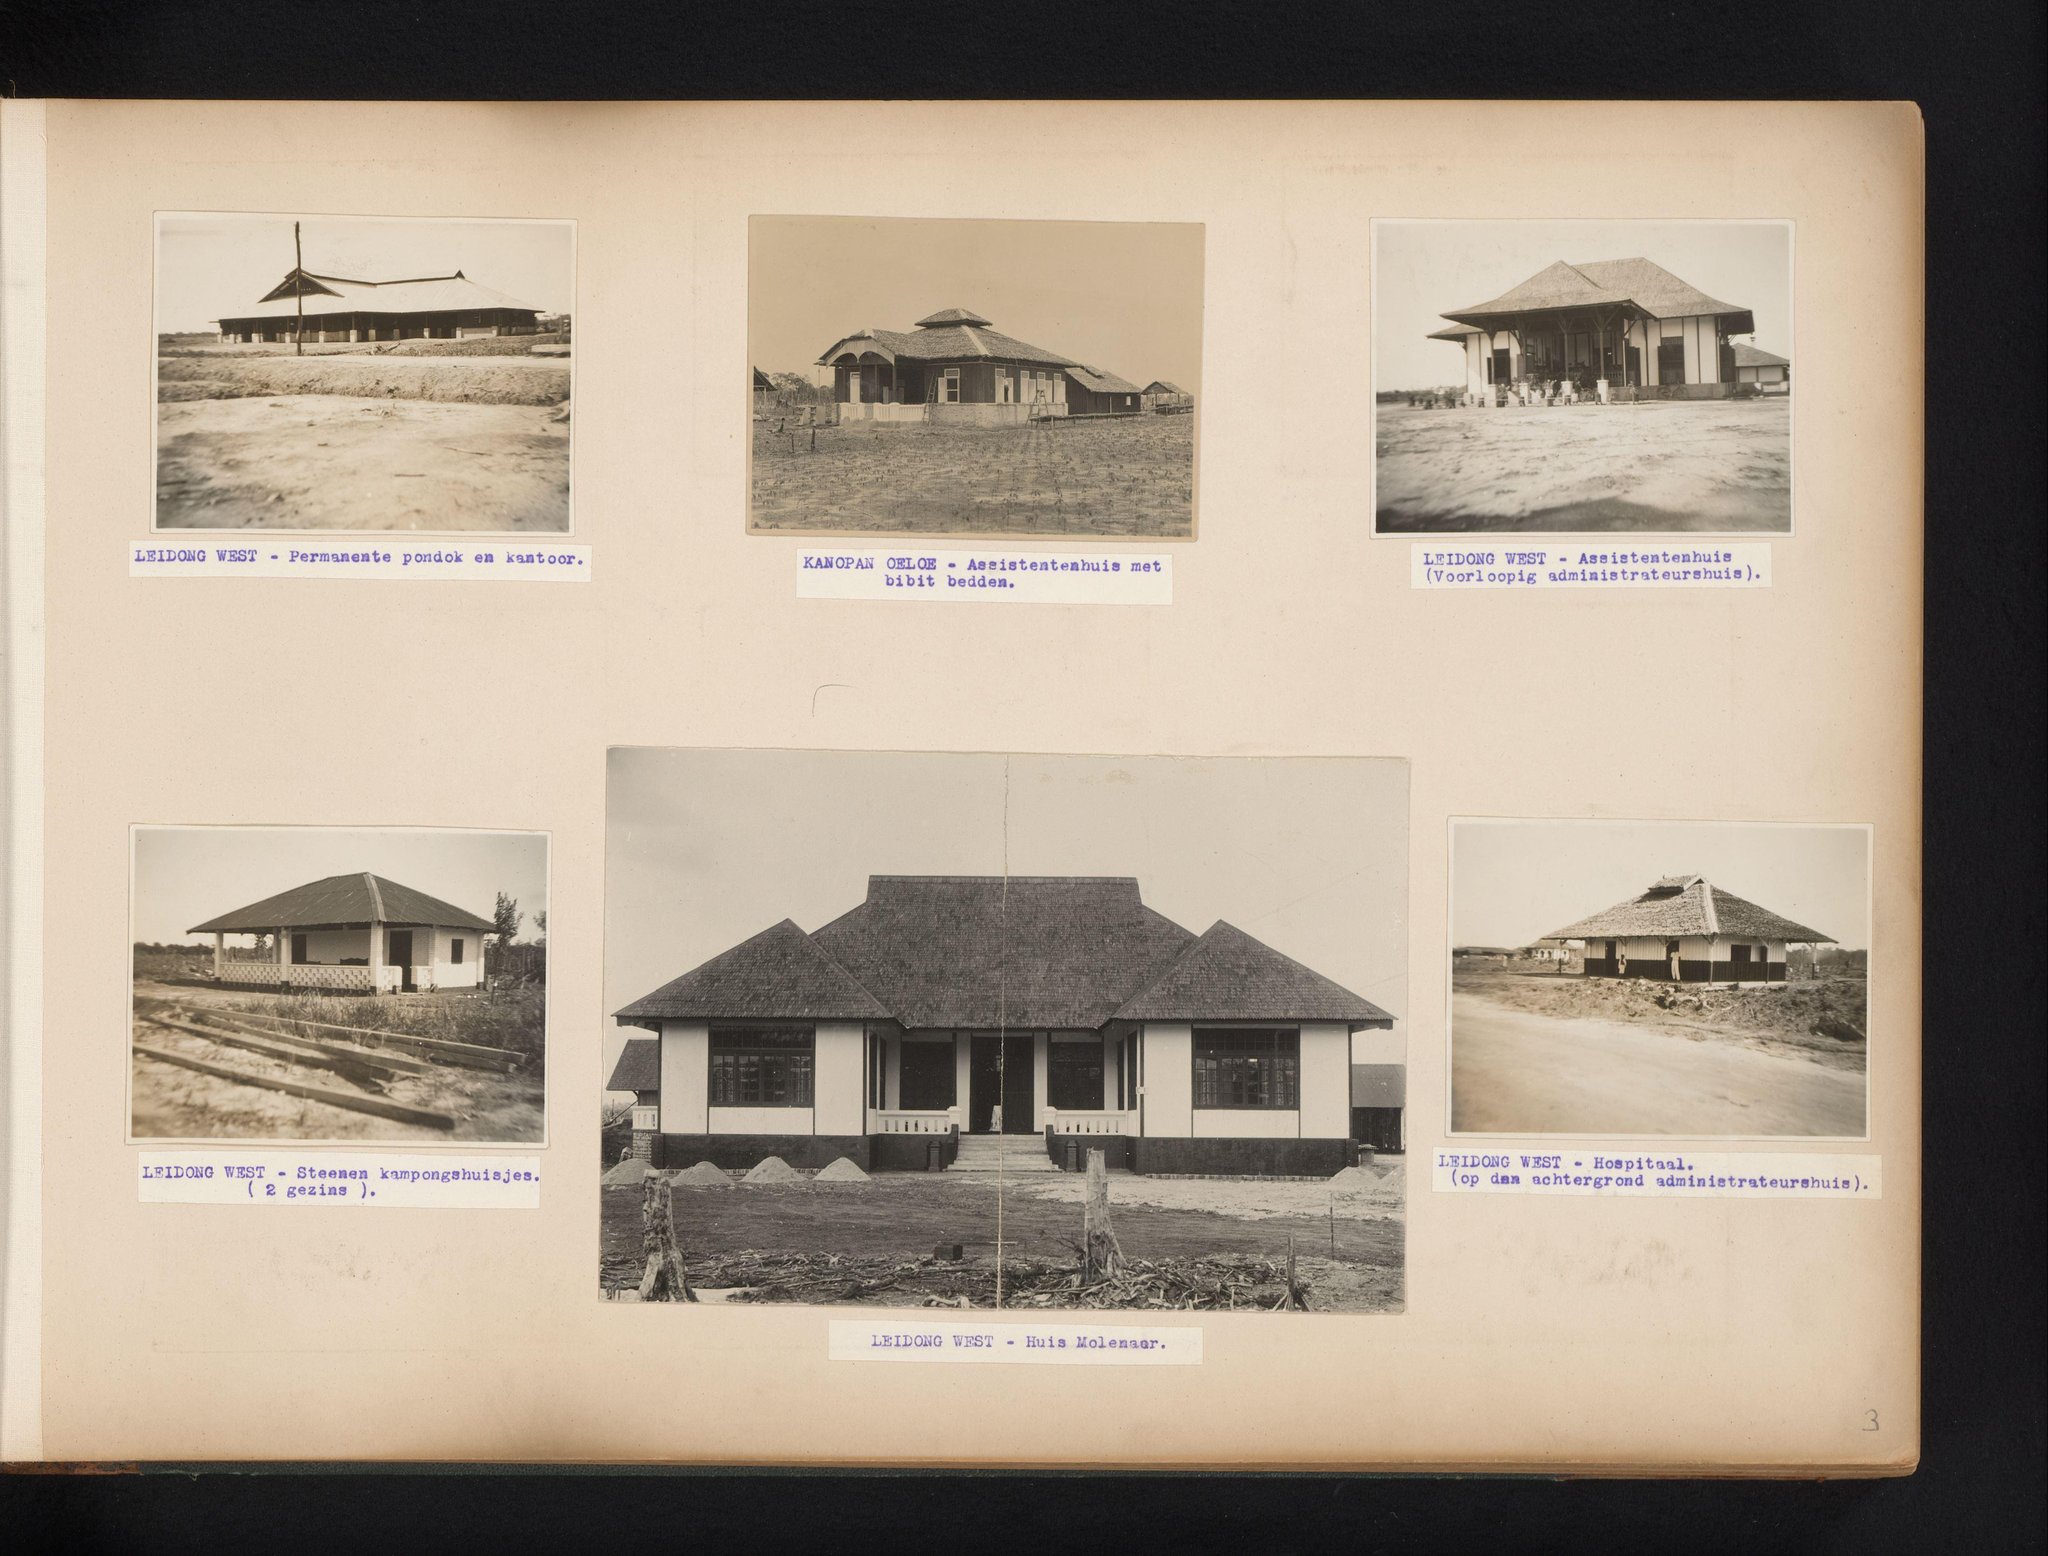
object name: photograph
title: Bedrijfsgebouwen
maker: Anonymous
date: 1927-1931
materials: cardboard, photographic support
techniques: gelatin silver print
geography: sumatra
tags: plantation, (non-fruit) products of plants or trees: rubber, sumatra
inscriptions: inscription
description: Blad met zes foto's van bedrijfsgebouwen op Leidong West en Kanopan Oeloe. Onderdeel van het fotoalbum over de plantages Leidong West en Kanopan Oeloe van de Cultuur Maatschappij Leidong West op Sumatra in de jaren 1925-1939.